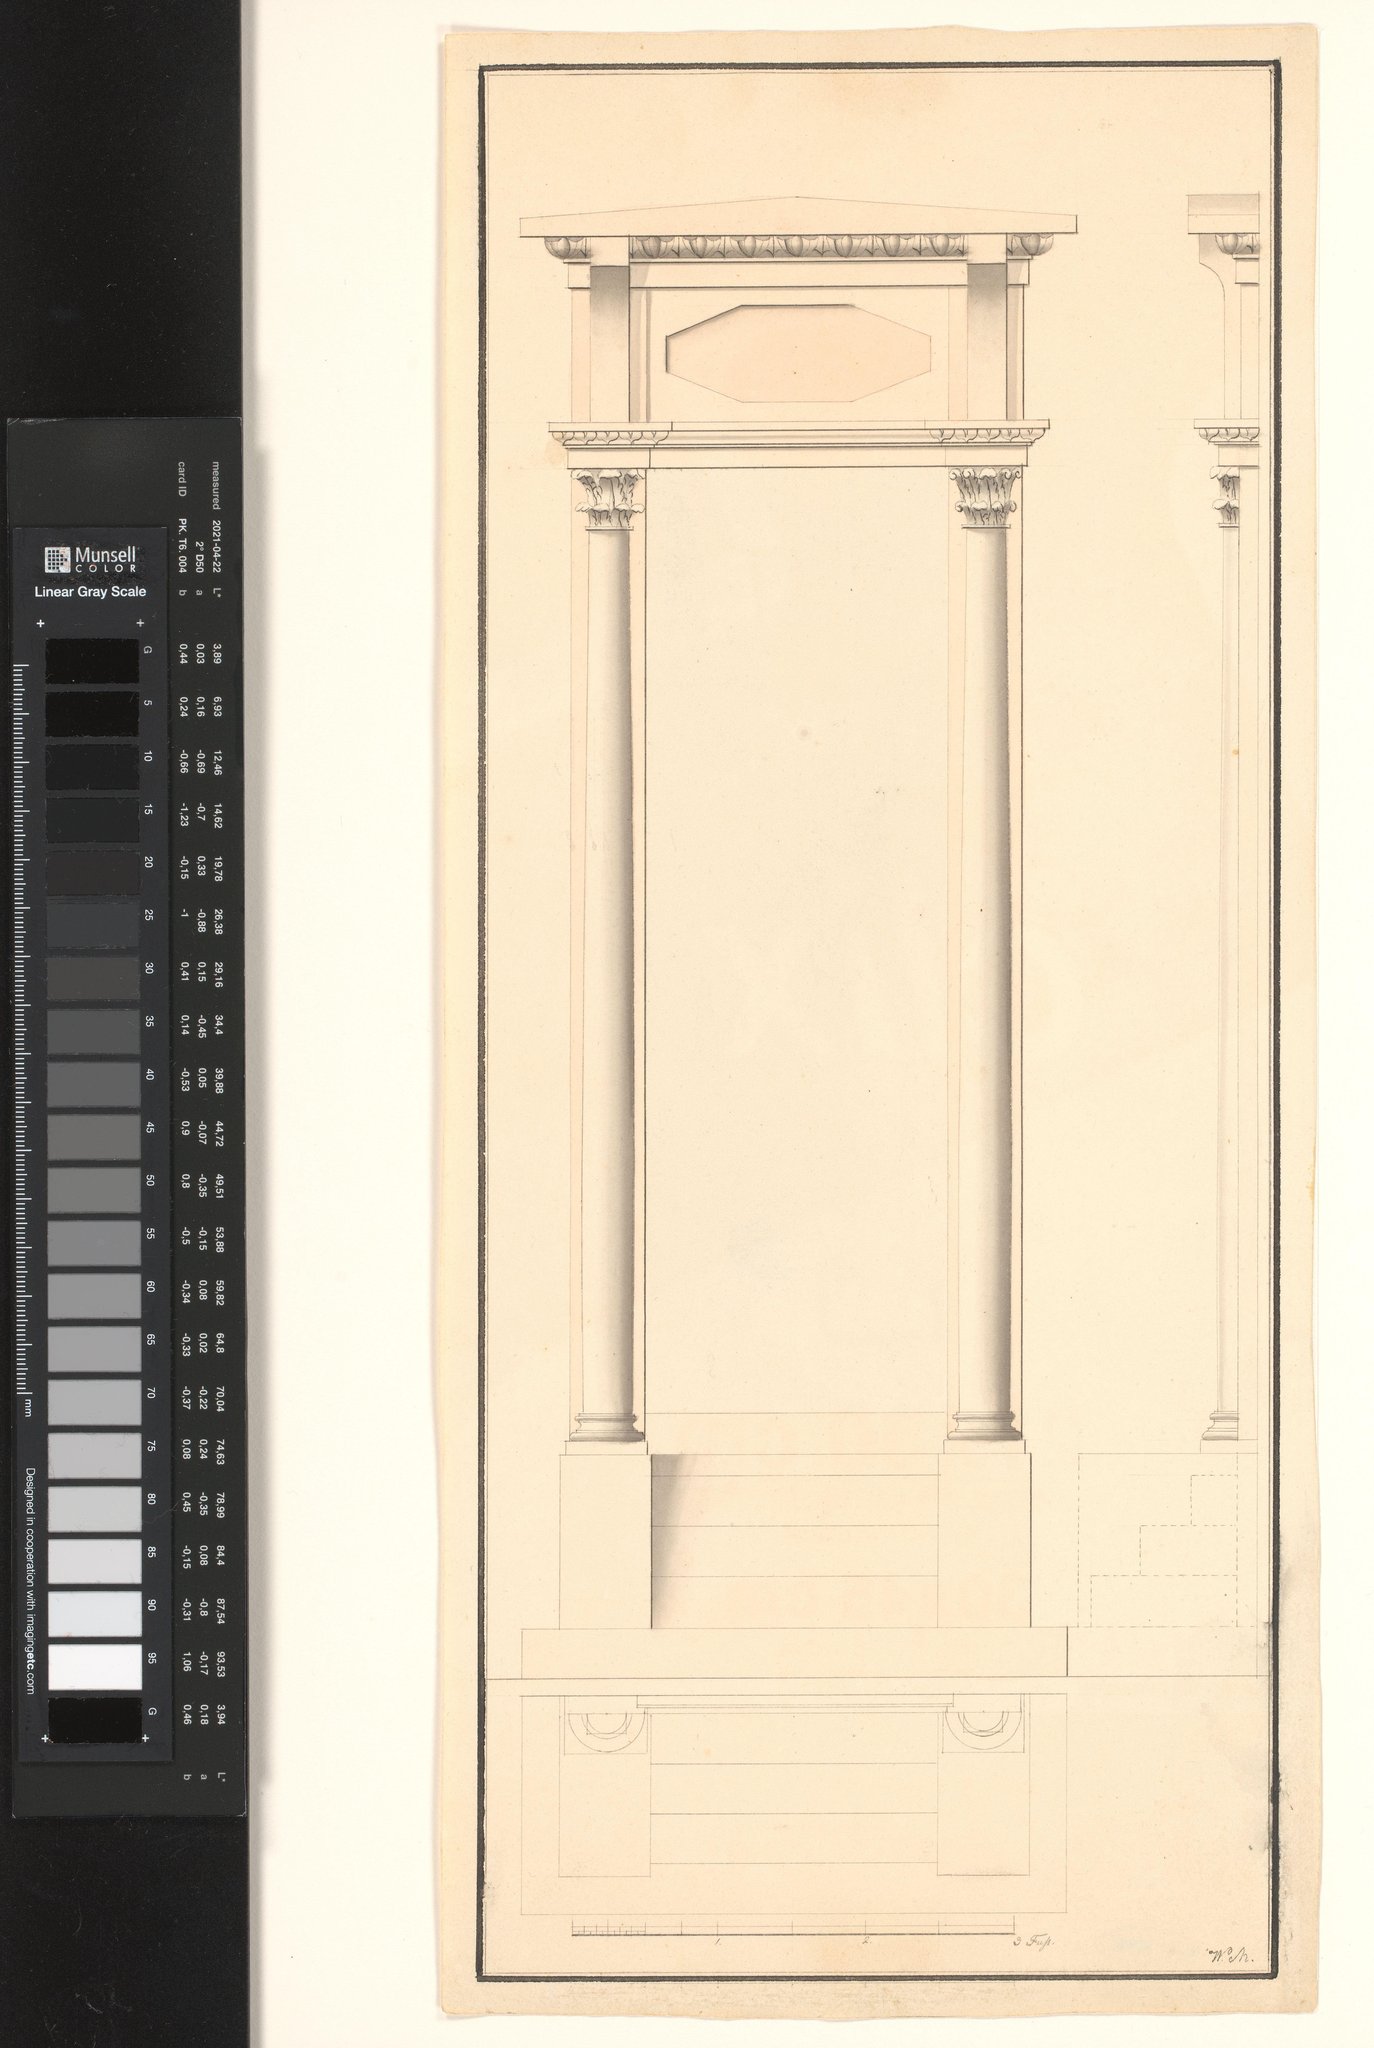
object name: design drawing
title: Ontwerp voor een spiegeltrumeau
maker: carl wilhelm marckwort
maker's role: draughtsman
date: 1820-1823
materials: ink, paper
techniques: brush, pen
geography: berlin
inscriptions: inscription: ‘1. / 2. / 3. Fuβ’, watermark: ‘J W[HATMAN]’, monogram: ‘W.M.’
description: Spiegeltrumeau met halfzuilen met palmetkapitelen, voor- en zijaanzicht met daaronder plattegrond en maatverdeling.